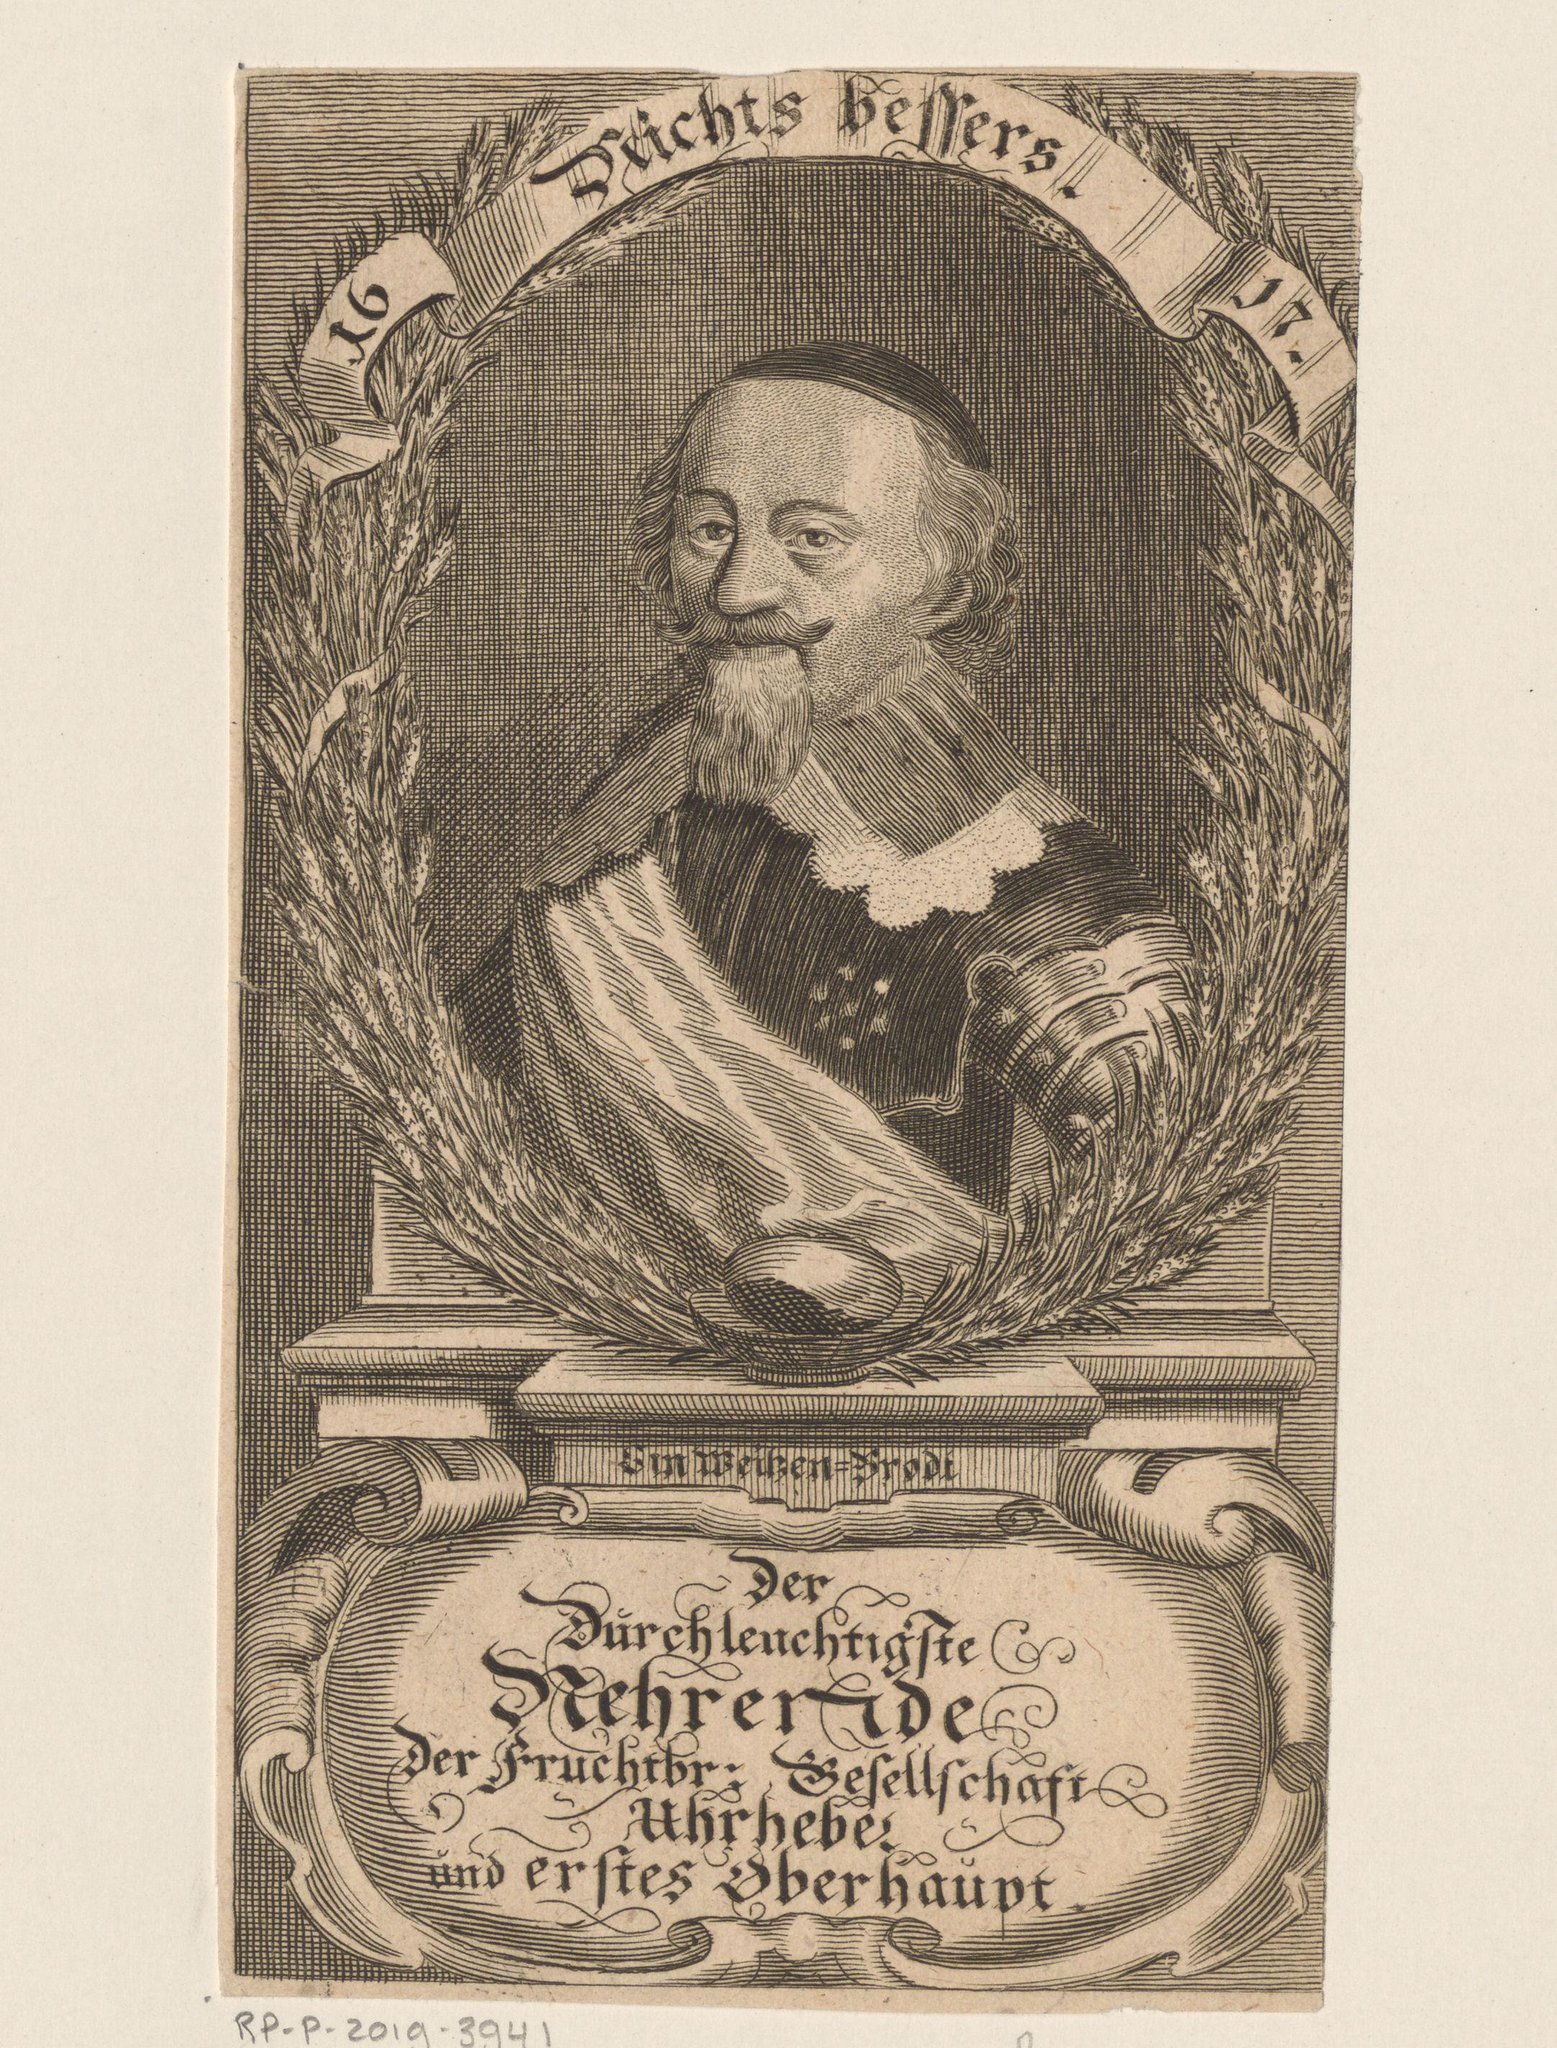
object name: print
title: Portret van August von Braunschweig-Lüneburg, hertog van Braunschweig-Wolfenbüttel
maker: Anonymous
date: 1650-1699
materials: paper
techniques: engraving, etching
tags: august von braunschweig-lüneburg (hertog van braunschweig-wolfenbüttel), armour, historical persons